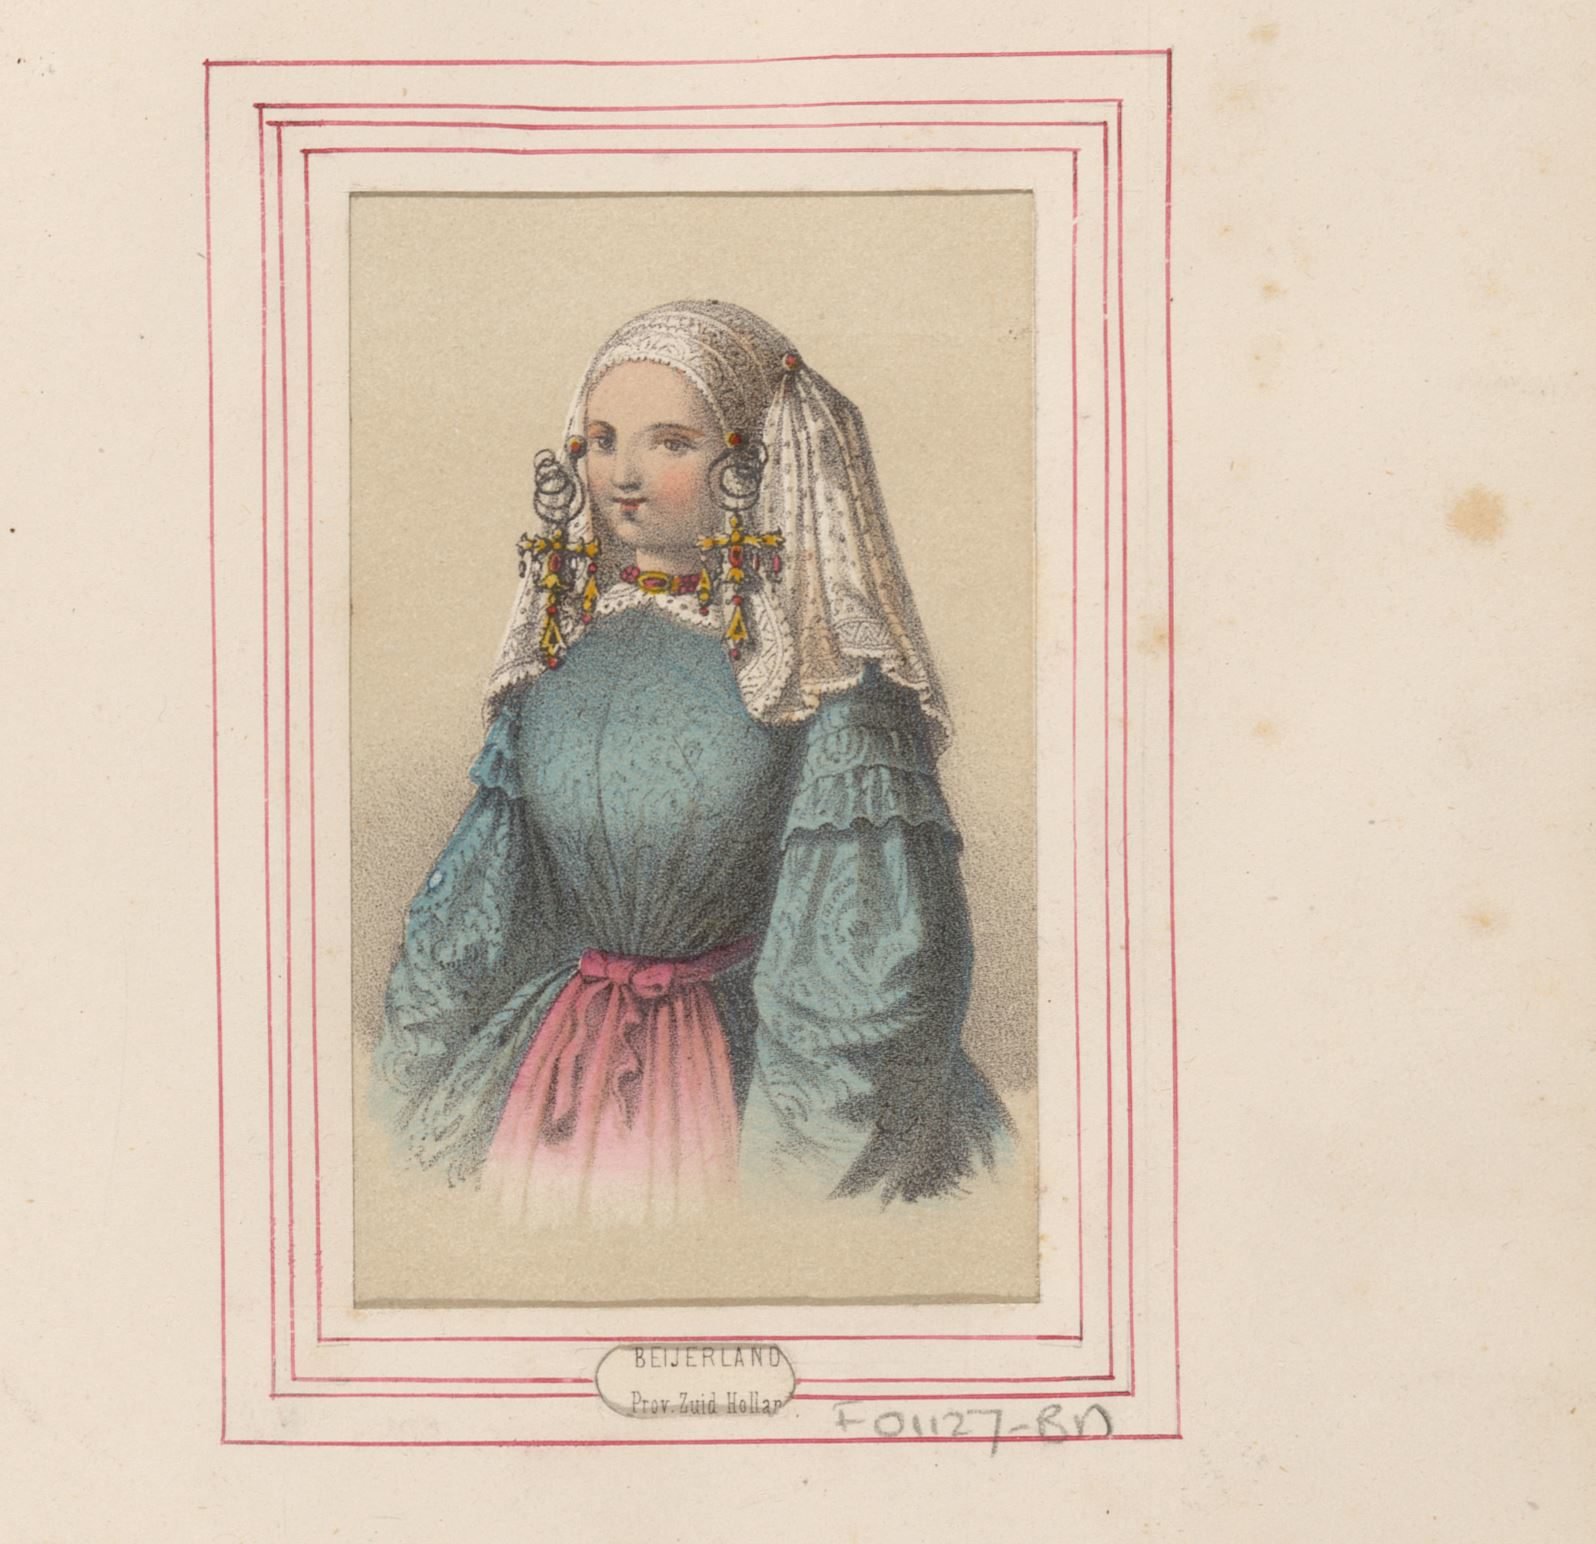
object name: print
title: Vrouw in de klederdracht van Beijerland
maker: Anonymous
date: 1865-1875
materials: paper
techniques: lithograph, hand coloring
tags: folk costume, regional costume (+ women's clothes), head-gear: cap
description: Onderdeel van Album met foto's en litho's van bezienswaardigheden in Noord- en Zuid-Hollandse steden, schilderijen en klederdrachten.